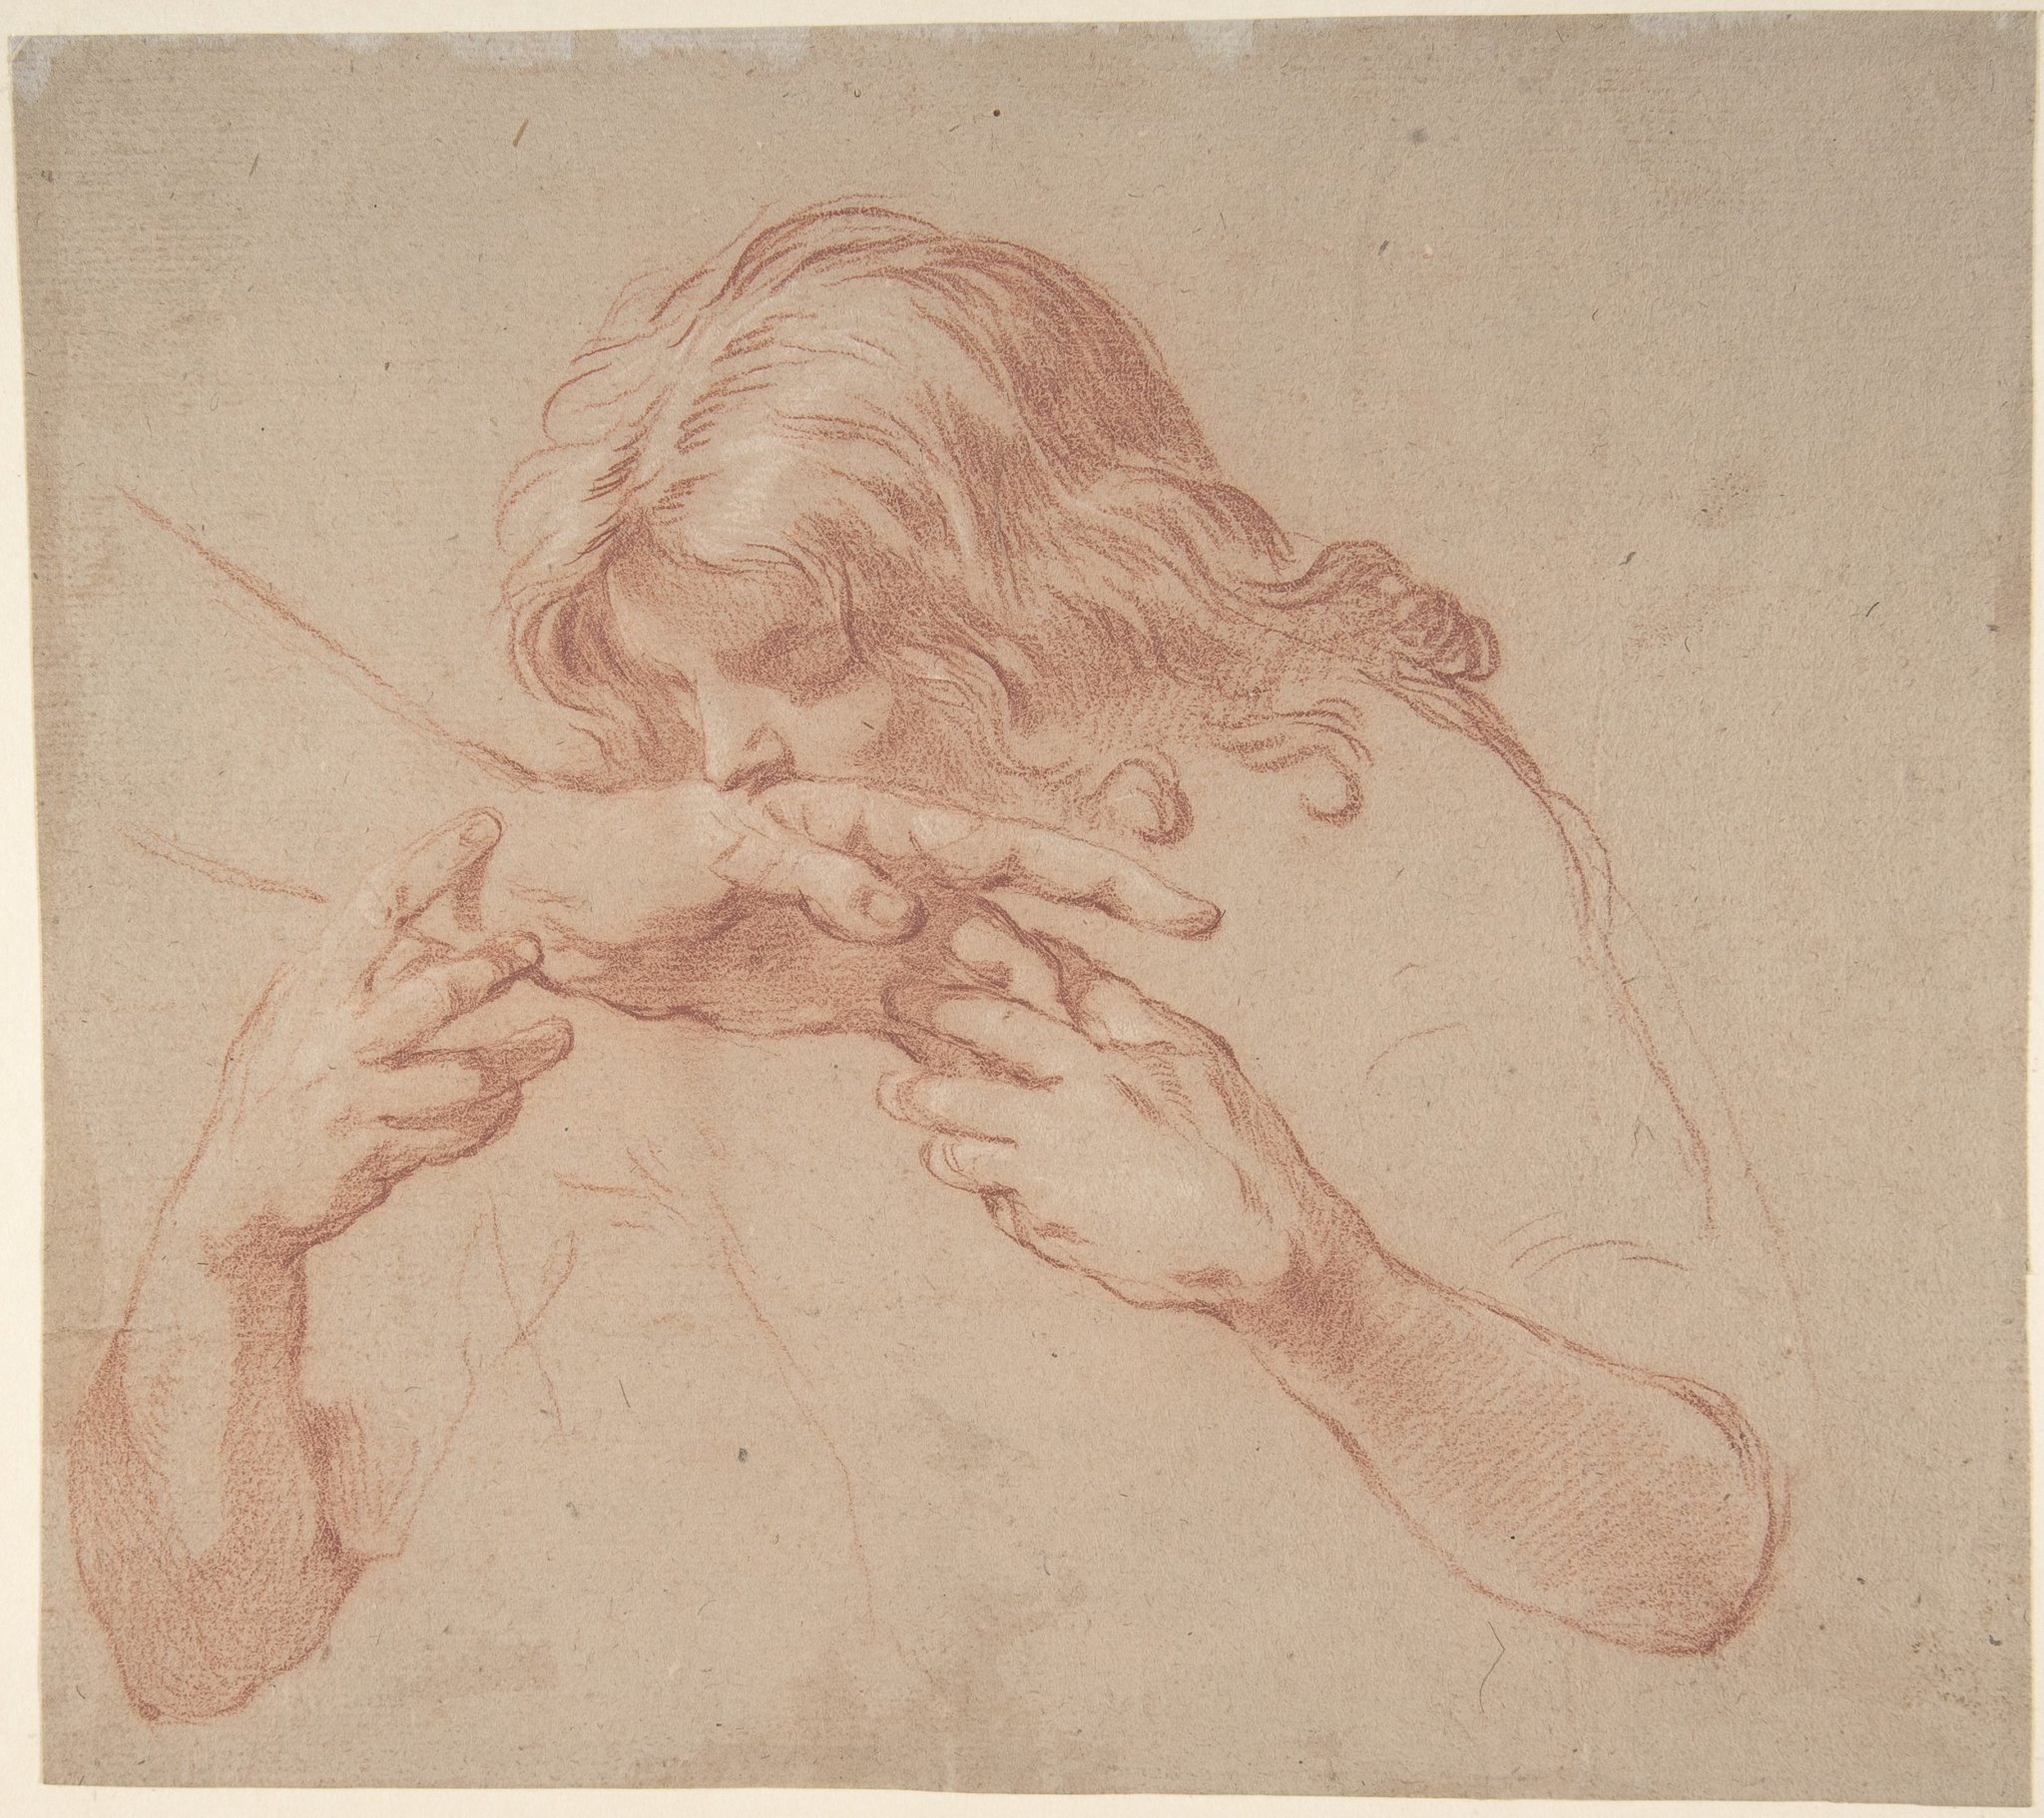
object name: drawing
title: Youth Kissing an Outstretched Hand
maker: marco benefial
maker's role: artist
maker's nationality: italian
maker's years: 1684-1764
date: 1684-1764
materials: chalk, paper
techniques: highlighting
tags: human figures,hands